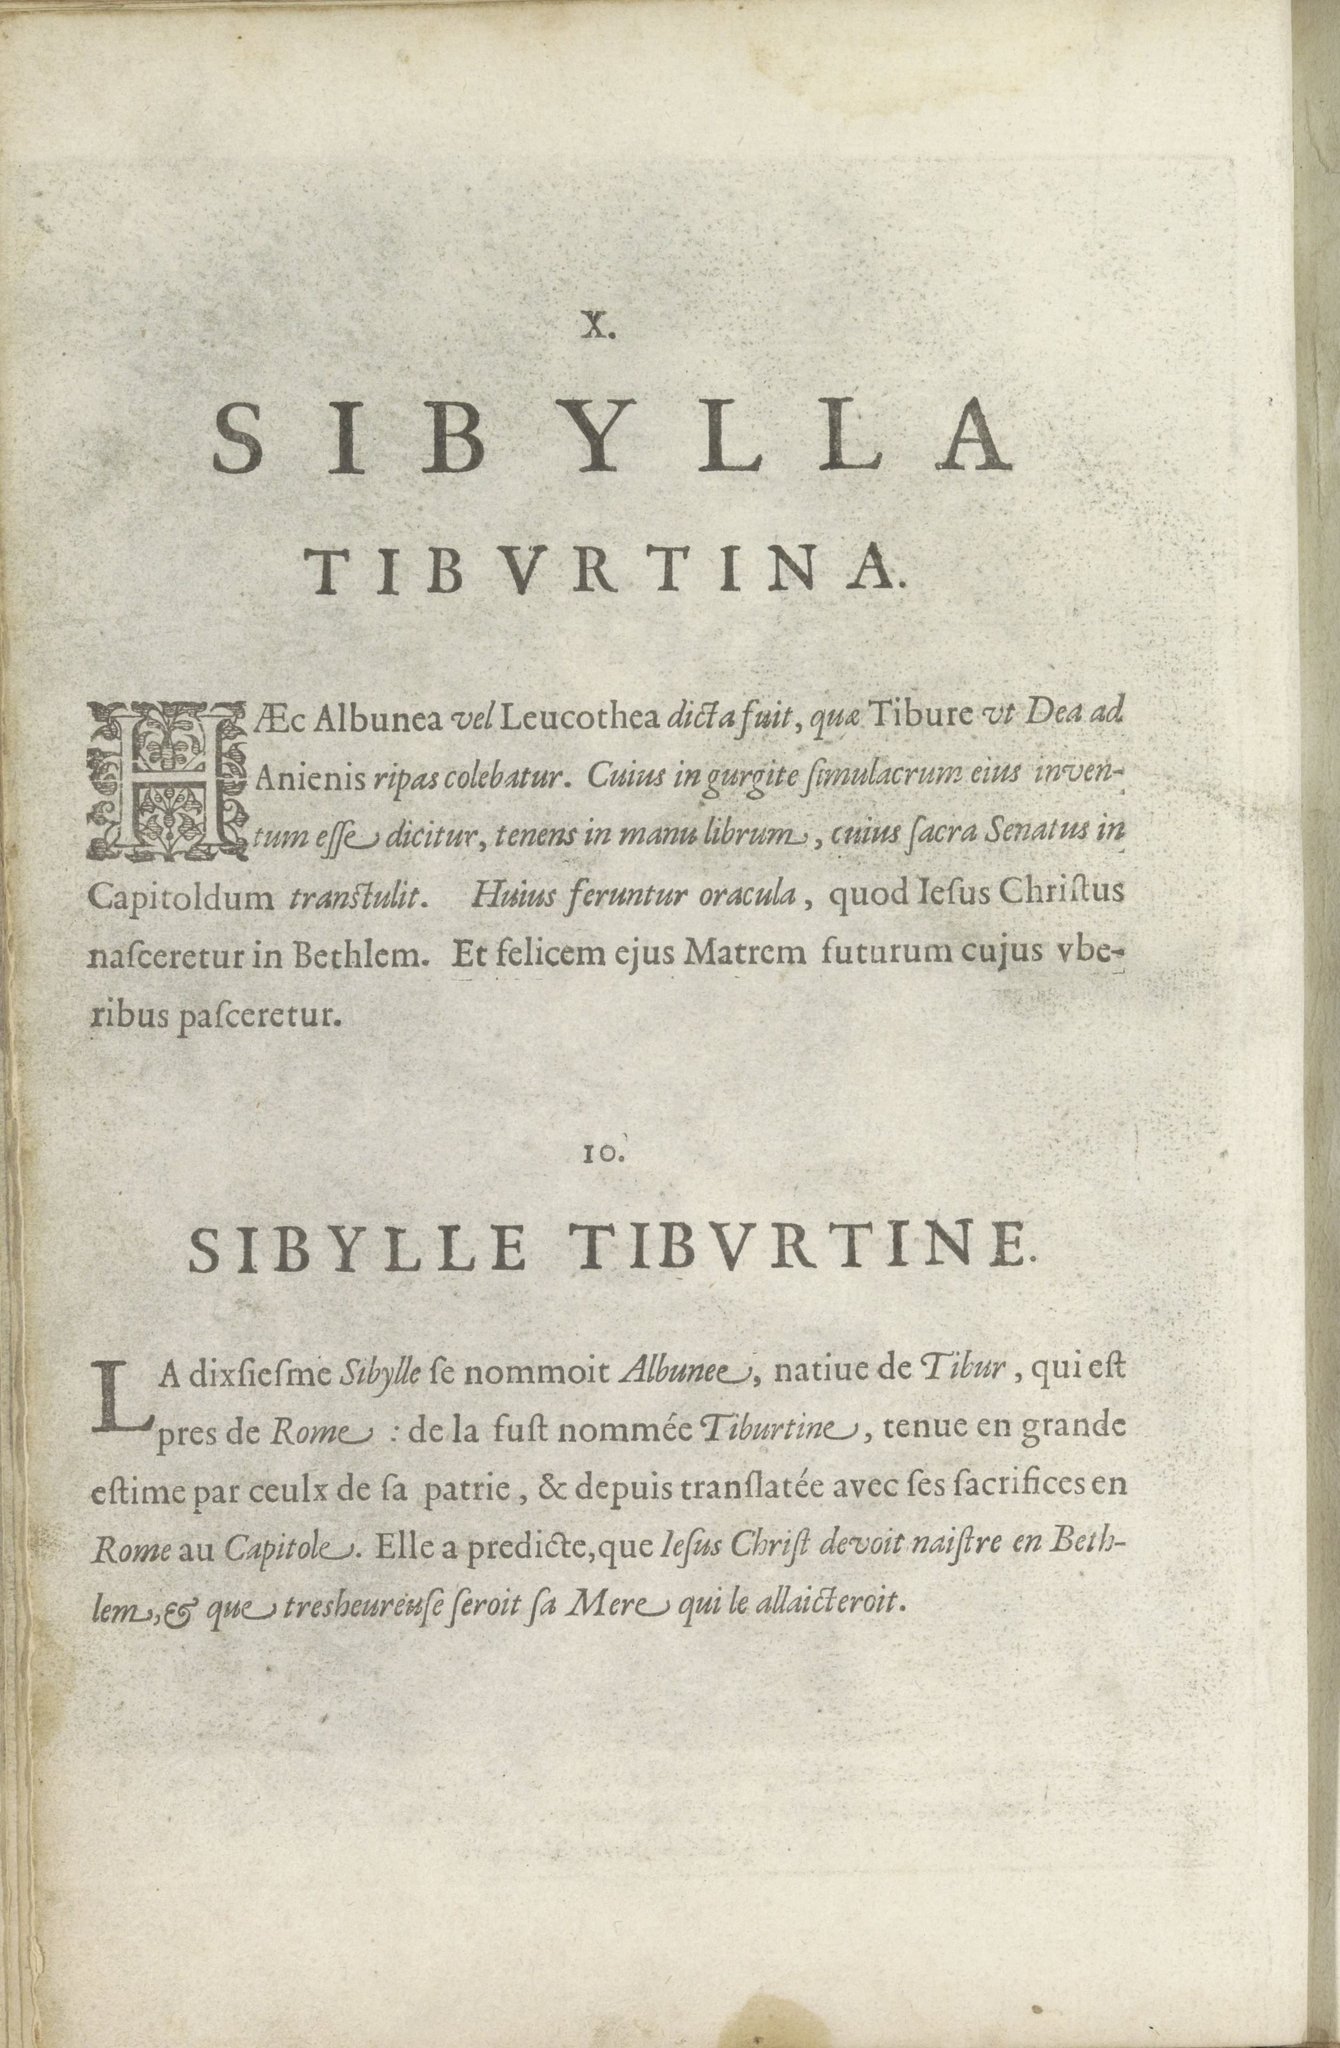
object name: text sheet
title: Tekstblad bij een voorstelling van de Tiburtijnse Sibille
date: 1615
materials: paper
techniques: letterpress printing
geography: utrecht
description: Een tekst in het Latijn en het Frans over een prent met een voorstelling van de Tiburtijnse Sibille. Dit blad maakt deel uit van een album.